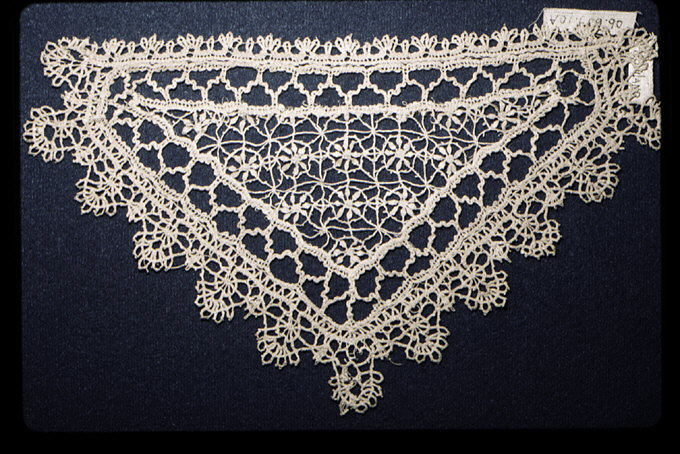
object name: cuff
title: Cuffs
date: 1650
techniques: lace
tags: flowers